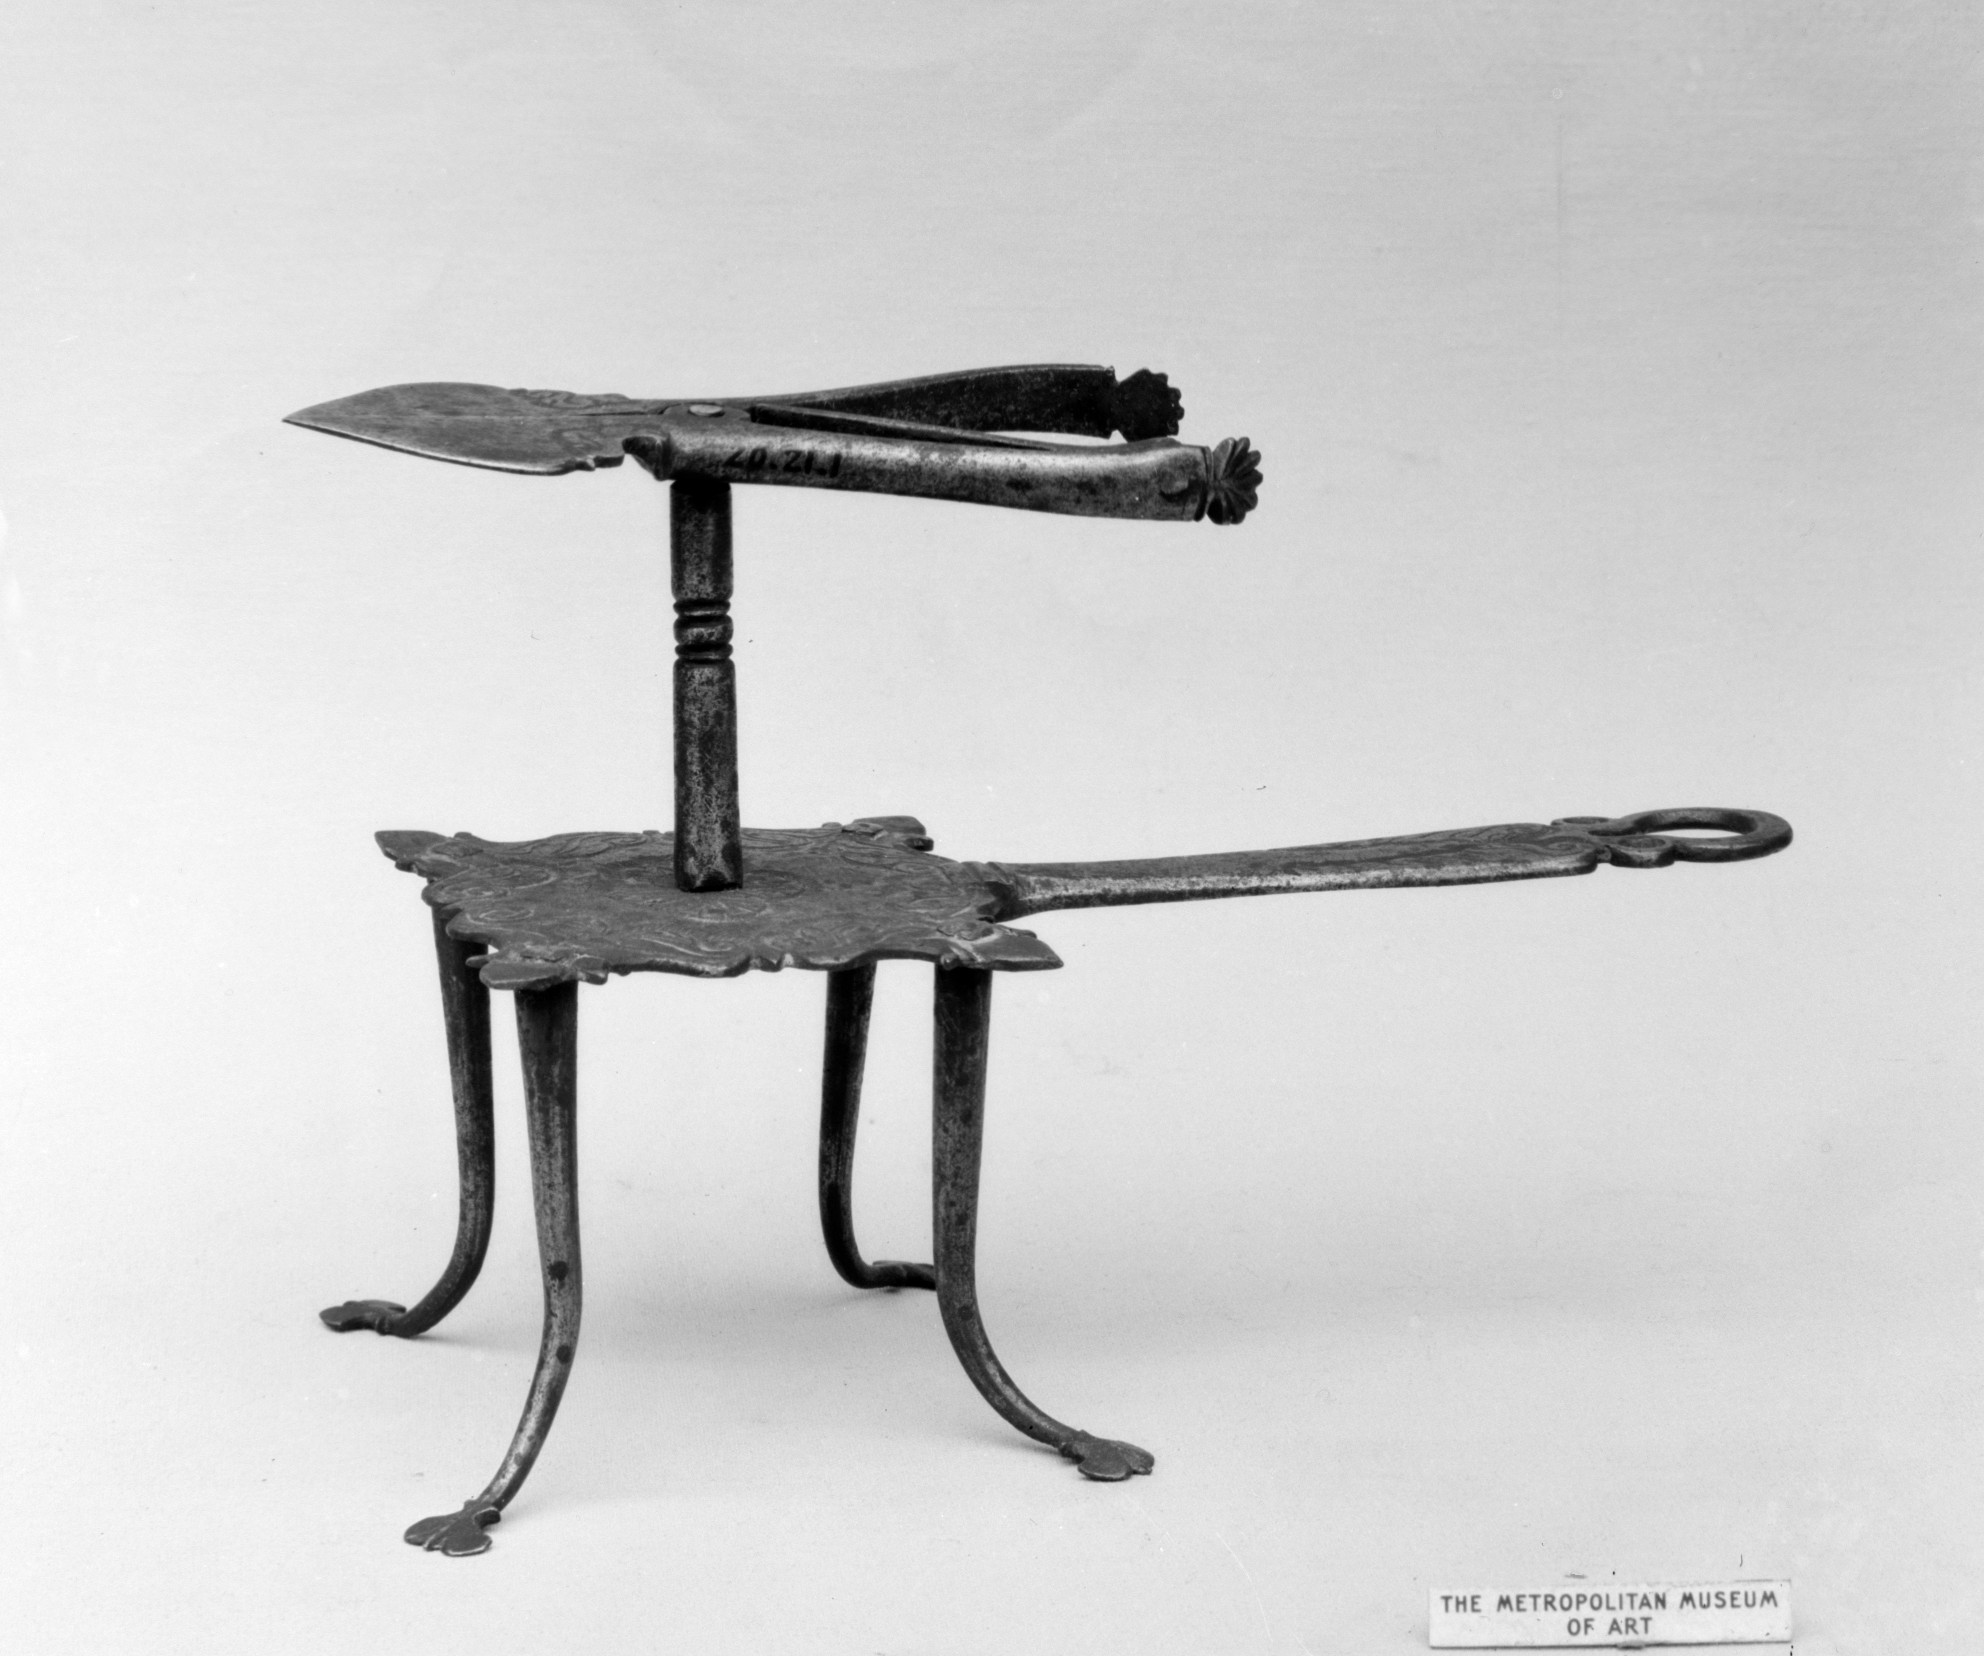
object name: wax taper holder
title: Wax-taper holder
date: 1601-1700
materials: steel